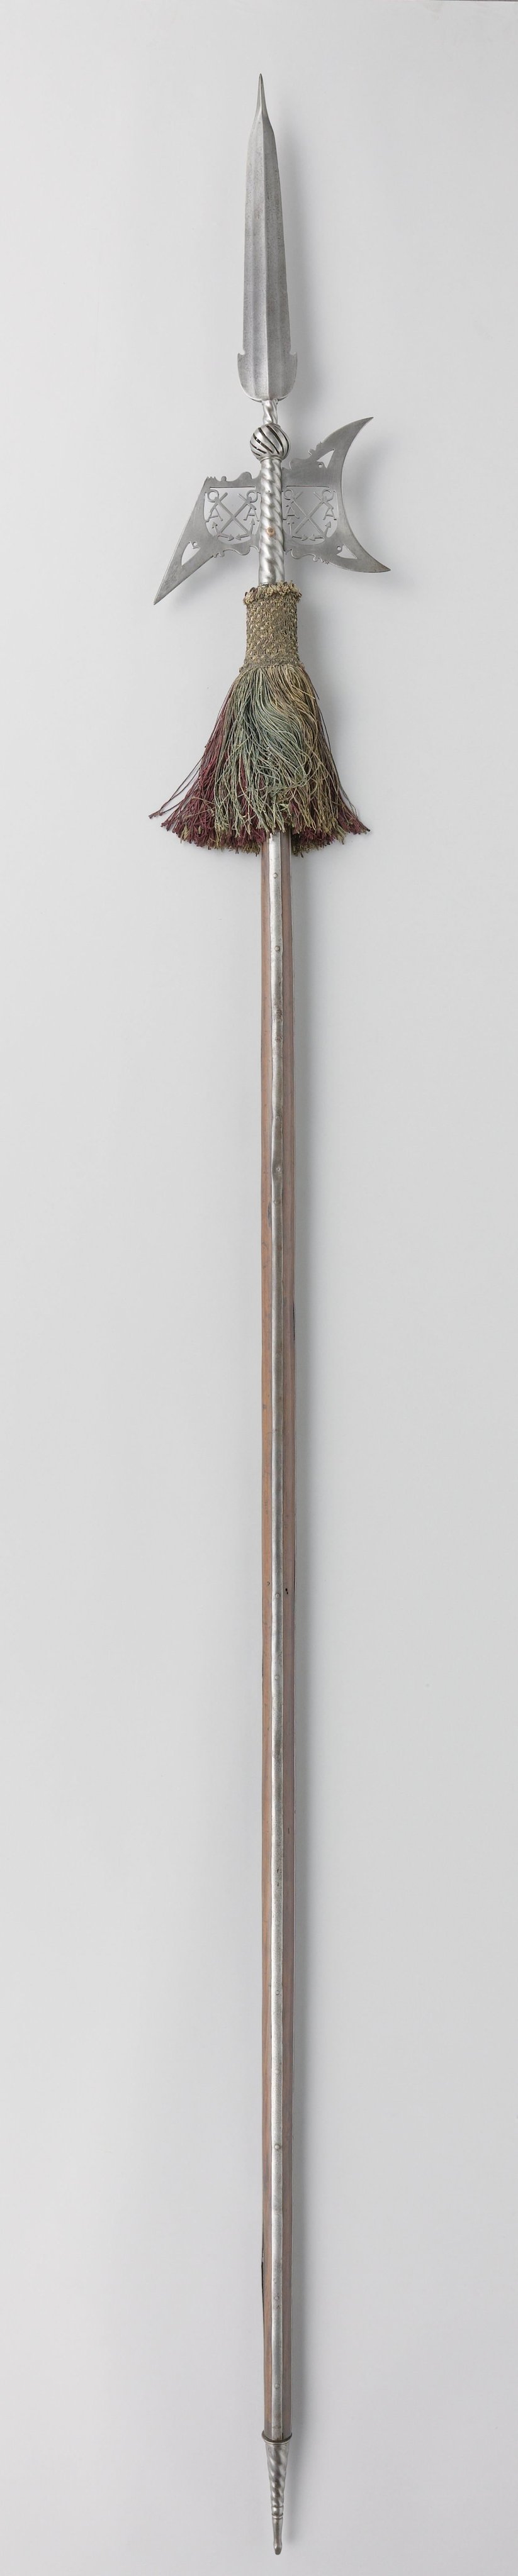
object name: halberd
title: Hellebaard met ronde stok en ijzeren punt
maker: Anonymous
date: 1599-1799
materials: iron, fiber, wood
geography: europe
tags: europe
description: Hellebaard met ijzeren kling toelopend in een punt met een gebolde middengraat, onderaan de kling twee opwaartse vleugels. Onder de kling een ijzeren bol met diagonaal naast elkaar gelegen uitsparingen. De bijl heeft de vorm van een halve maan en heeft op het blad aan beide zijden uitsparingen in de vorm van twee gekruiste ankers. Het huis is geribbeld. De schacht heeft aan vier zijden veren over de gehele lengte. De schoen is van ijzer en aflopend in een punt.